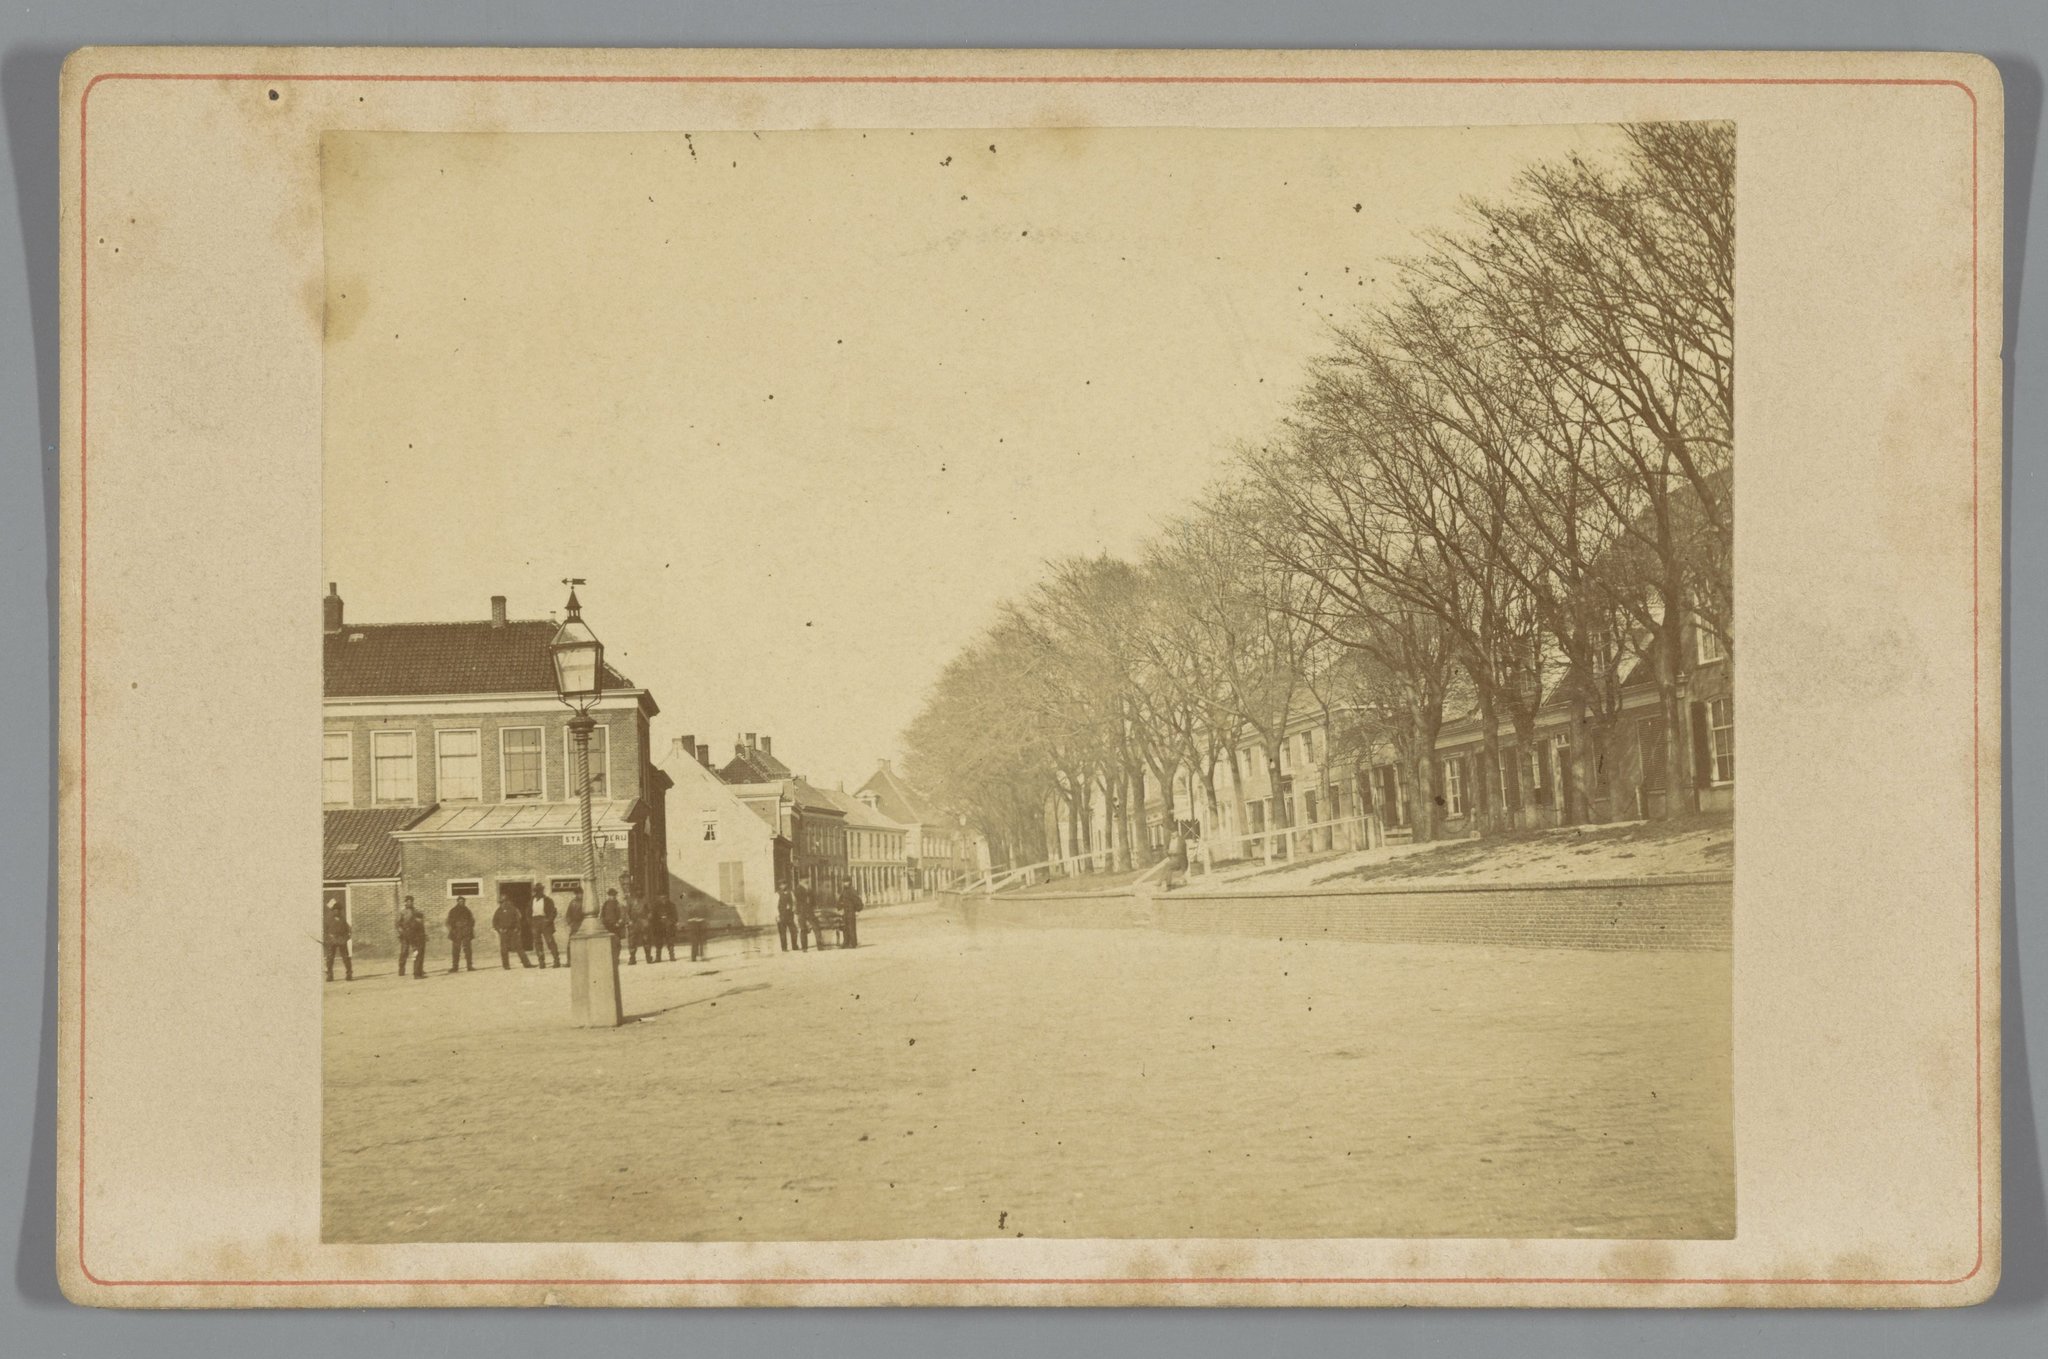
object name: cabinet photograph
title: Den Helder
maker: Anonymous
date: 1878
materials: cardboard, paper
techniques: albumen print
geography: den helder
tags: square, place, circus, etc., stall, stable, den helder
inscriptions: collector's mark: ‘Vosmaer’